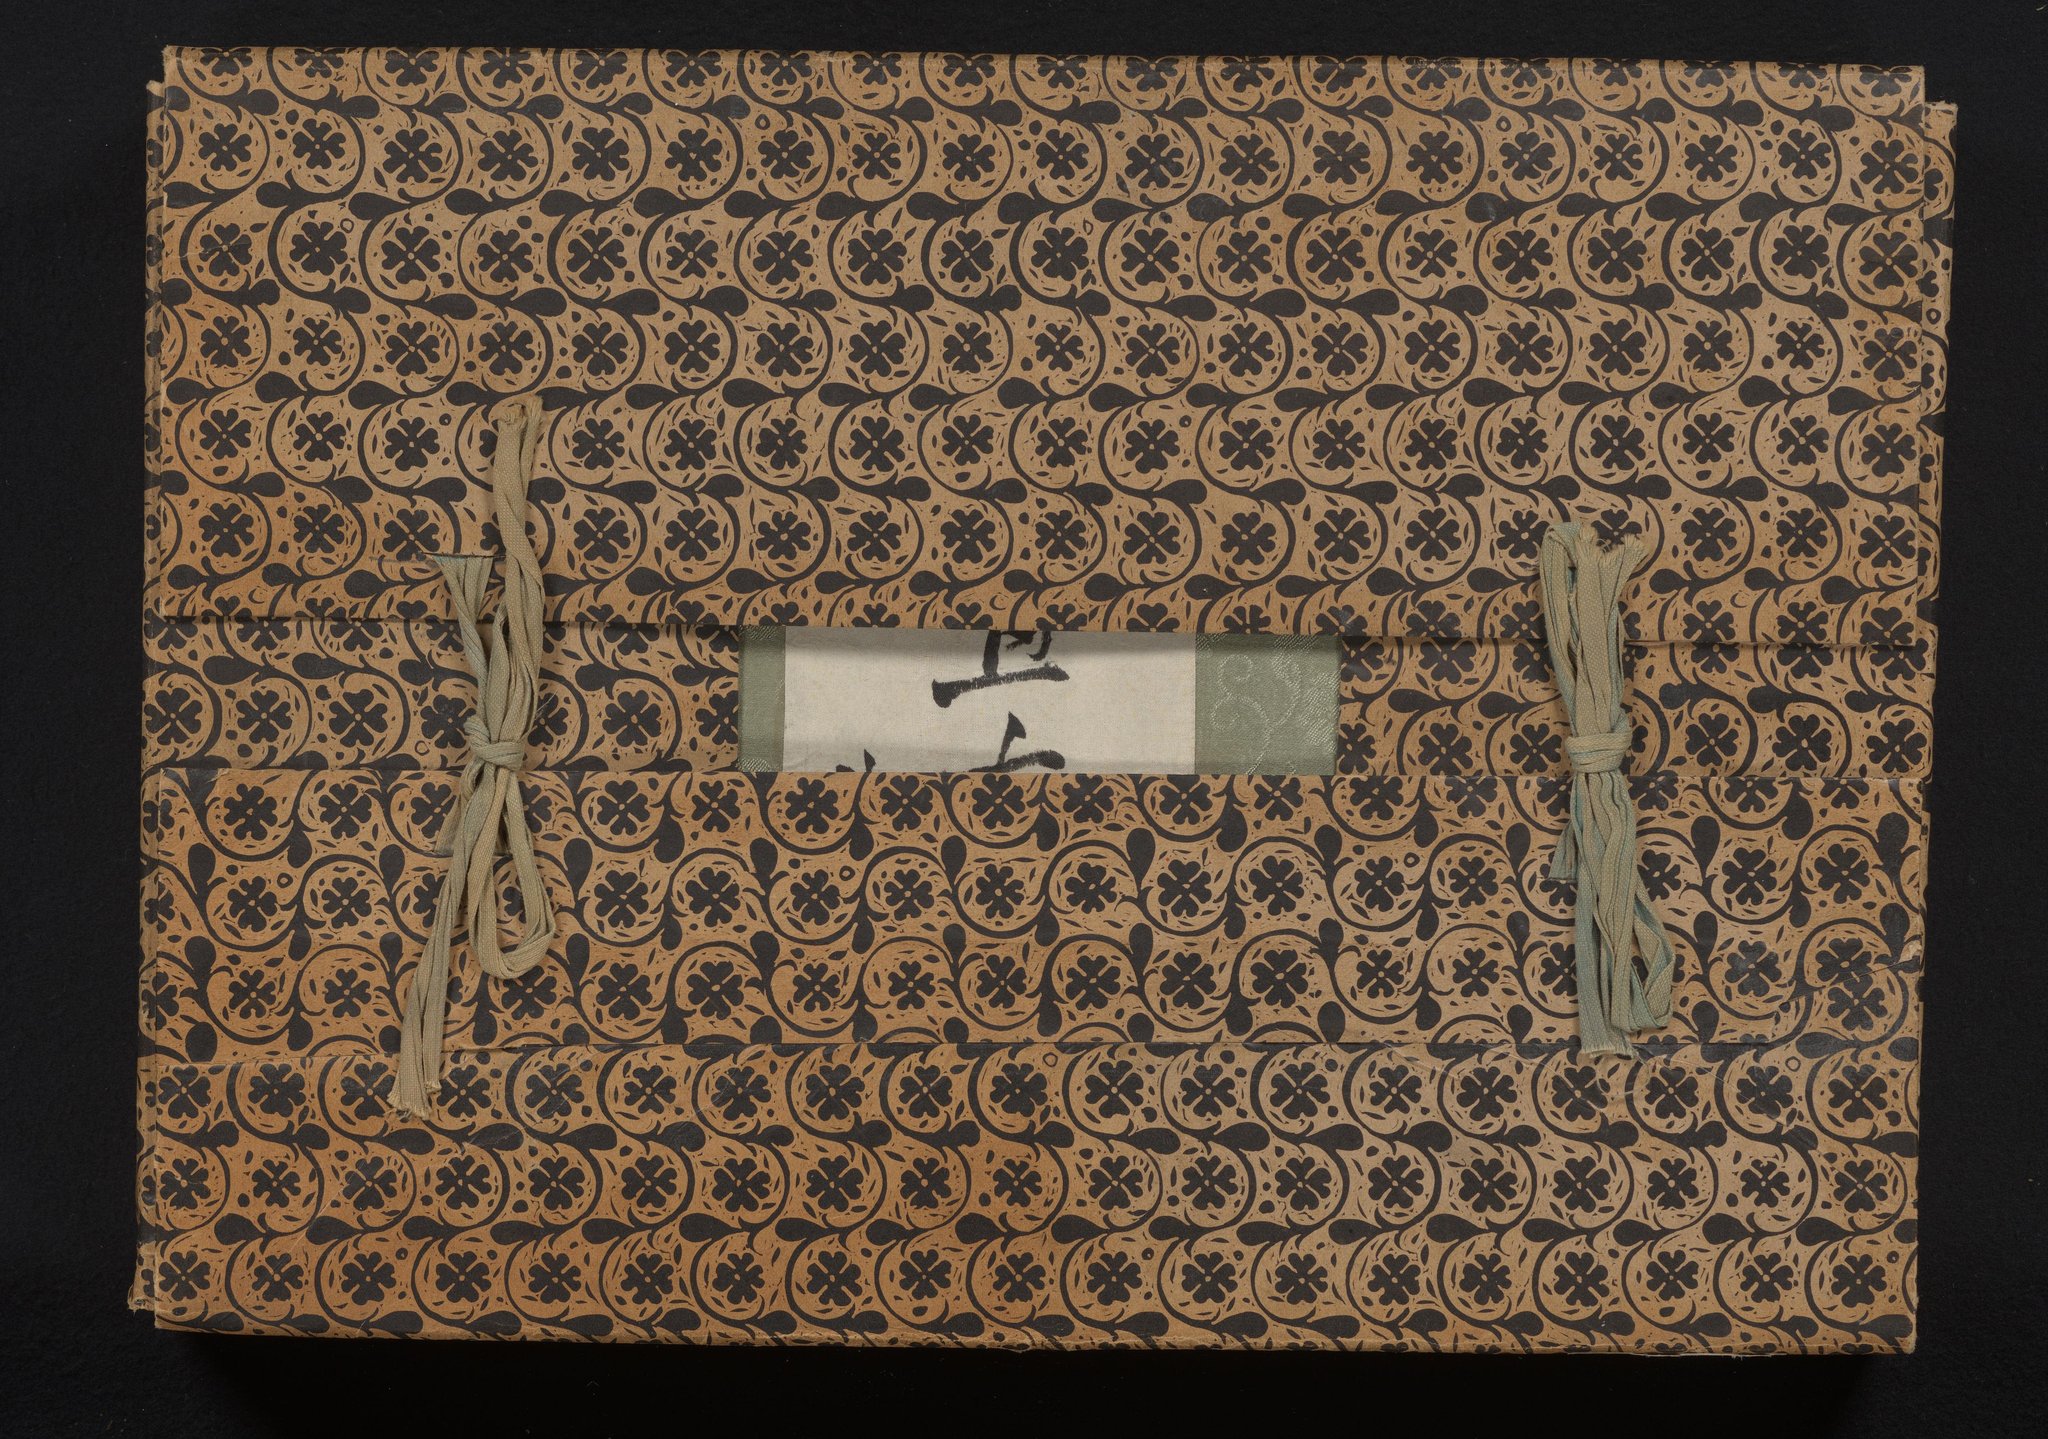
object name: folder container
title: Enceclopedie van Noh toneelstukken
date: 1925-1926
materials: cardboard, paper, ribbon, silk, textile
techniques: woodcut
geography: japan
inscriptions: date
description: Vier albums met ieder 40 illustraties van scenes uit Noh toneelstukken.